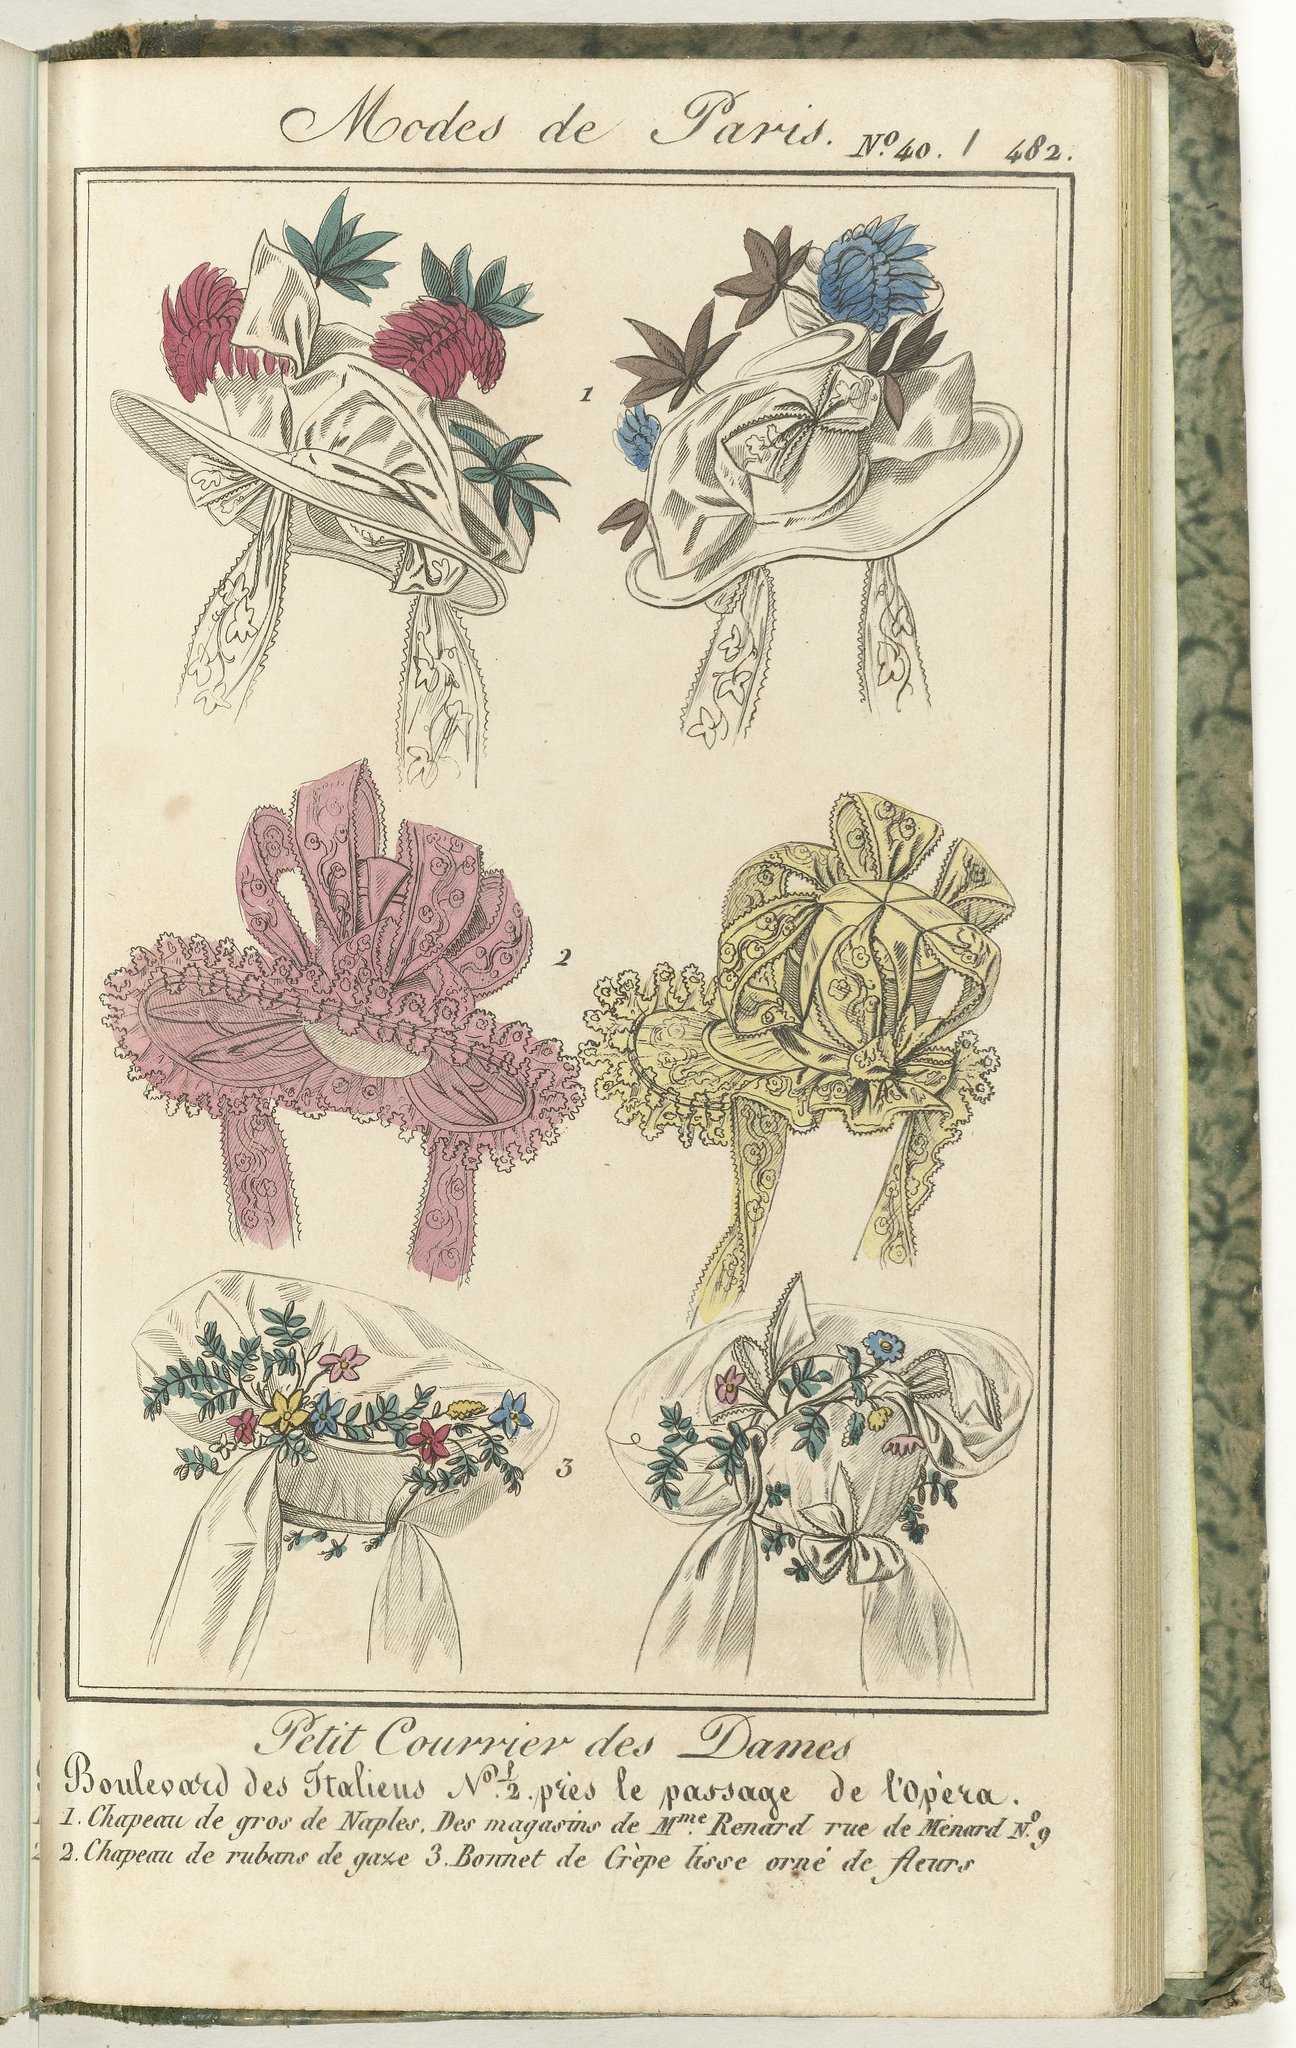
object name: fashion print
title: Petit Courrier des Dames, 1827, No. 40 / 482: 1. Chapeau de gros de Naples...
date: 1827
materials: paper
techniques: engraving, hand coloring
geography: paris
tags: flowers, border, ribbon, braid (+ women's clothes), head-gear: cap (+ women's clothes), fashion plates, head-gear: hat (+ women's clothes)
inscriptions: title: ‘Modes de Paris.’, address: ‘Boulevard des Italiens No.2 près le passage de l'Opèra.’, caption: ‘1. Chapeau de gros de Naples. Des magasins de M.me Renard rue de Menard No. 9. 2. Chapeau de rubans de gaze 3. Bonnet de Crèpe lisse orné de fleurs.’, title: ‘Petit Courrier des Dames.’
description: Drie verschillende hoofddeksels, van de voor- en achterkant weergegeven, genummerd één tot en met drie. 1. Hoed van 'gros de Naples', uit de winkels van Renard. 2. Hoed van linten van gaas. 3. Muts van 'crêpe lisse' versierd met bloemen. Prent uit het modetijdschrift Petit Courrier des Dames (1821-1868). Ingebonden (met enkele pp. Le Journal des Dames et des Modes). 15 Januari 1827 t/m 20 maart 1830. Incompleet.